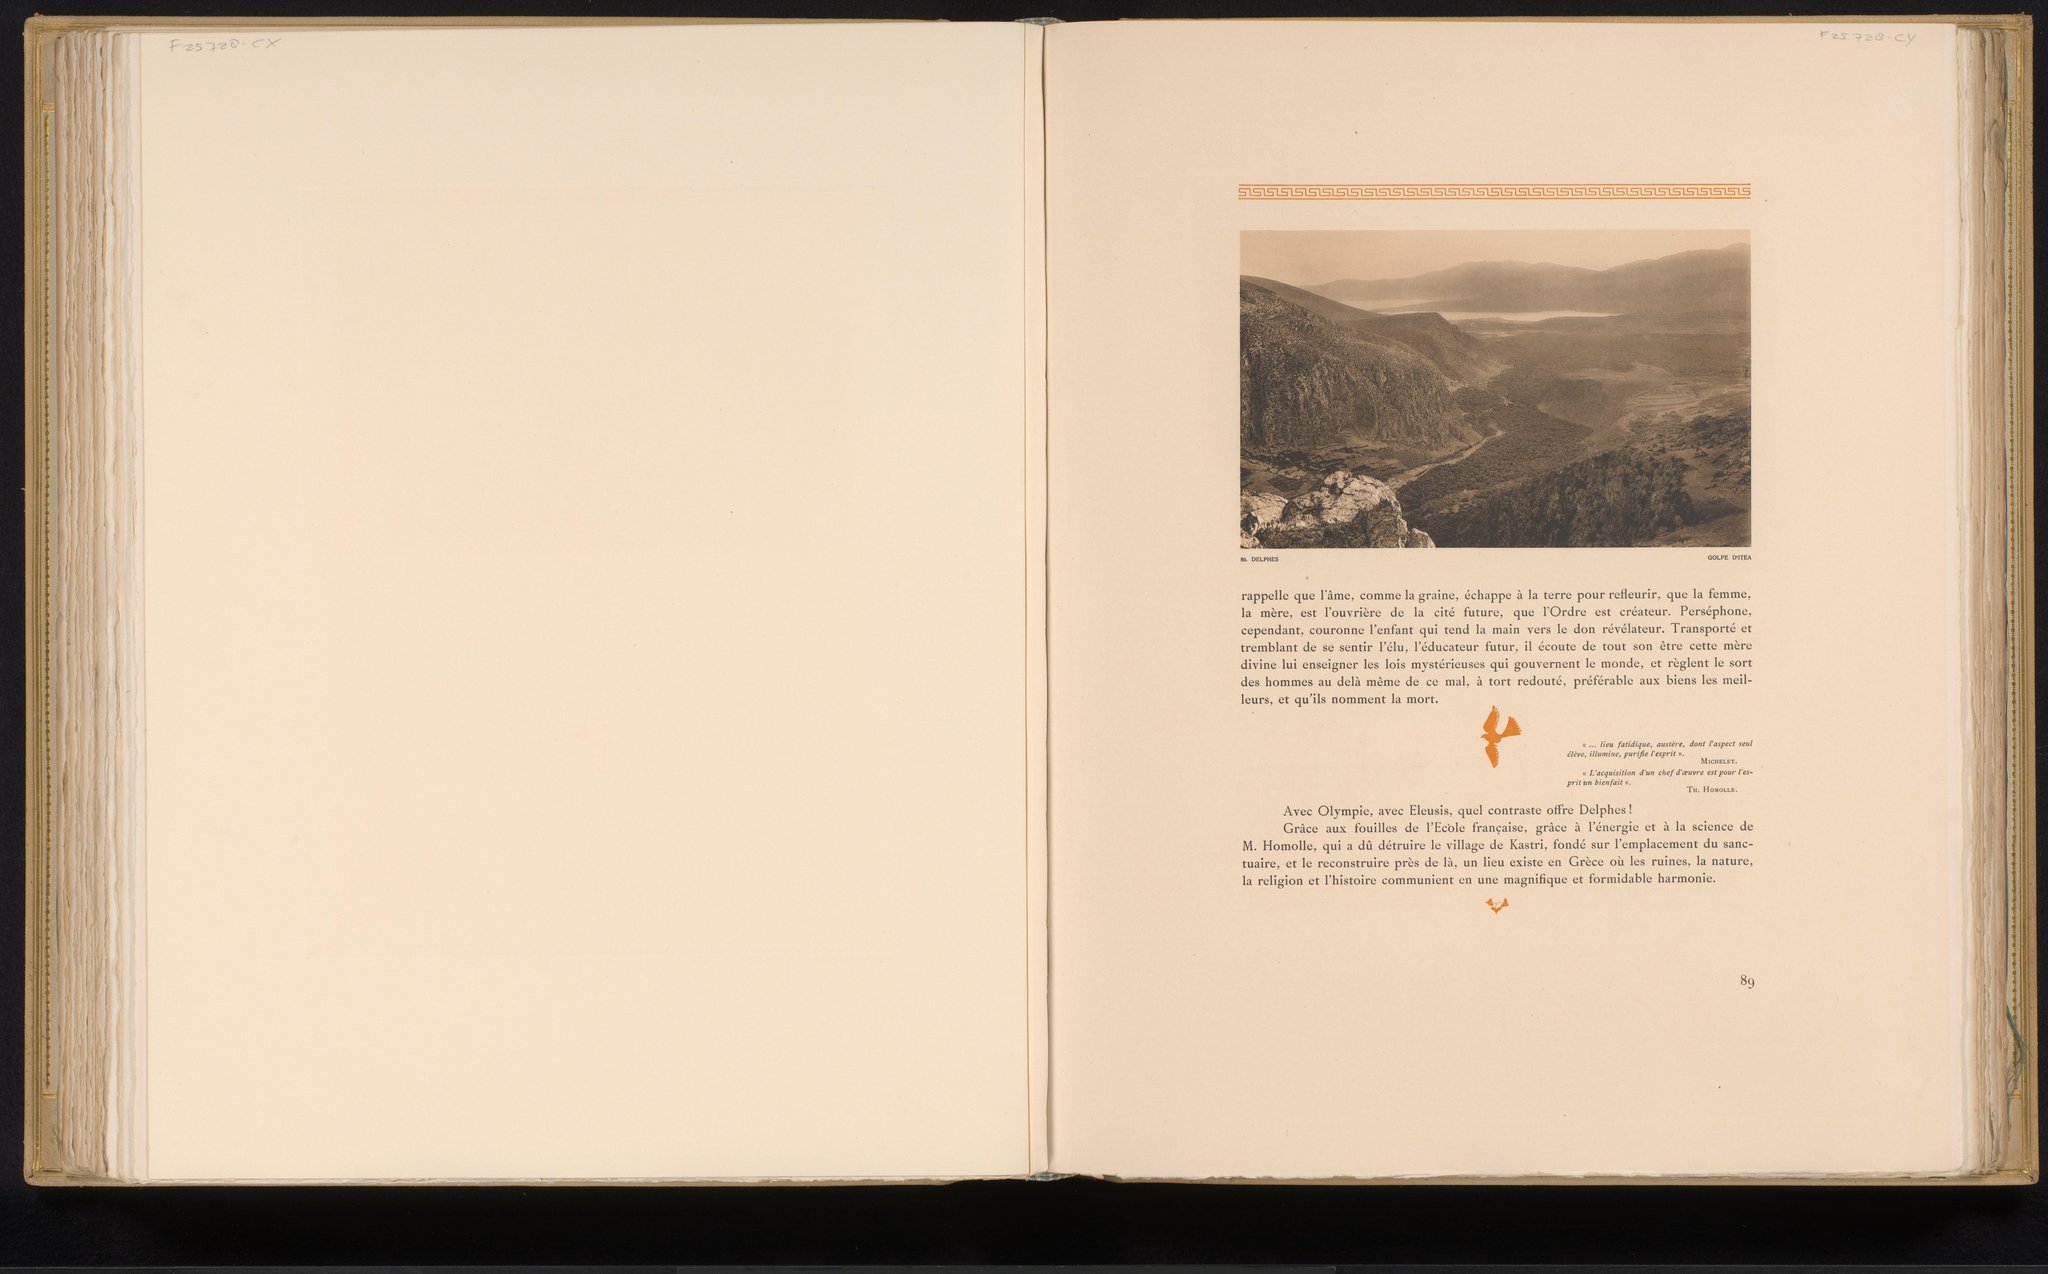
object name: page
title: Gezicht op het landschap rond Itea bij Delphi, in de verte de Golf van Itea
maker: frédéric boissonnas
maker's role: fotograaf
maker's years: 1858-1946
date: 1905-1910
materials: paper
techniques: photograph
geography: berlin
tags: gulf, bay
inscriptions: number: ‘80.’